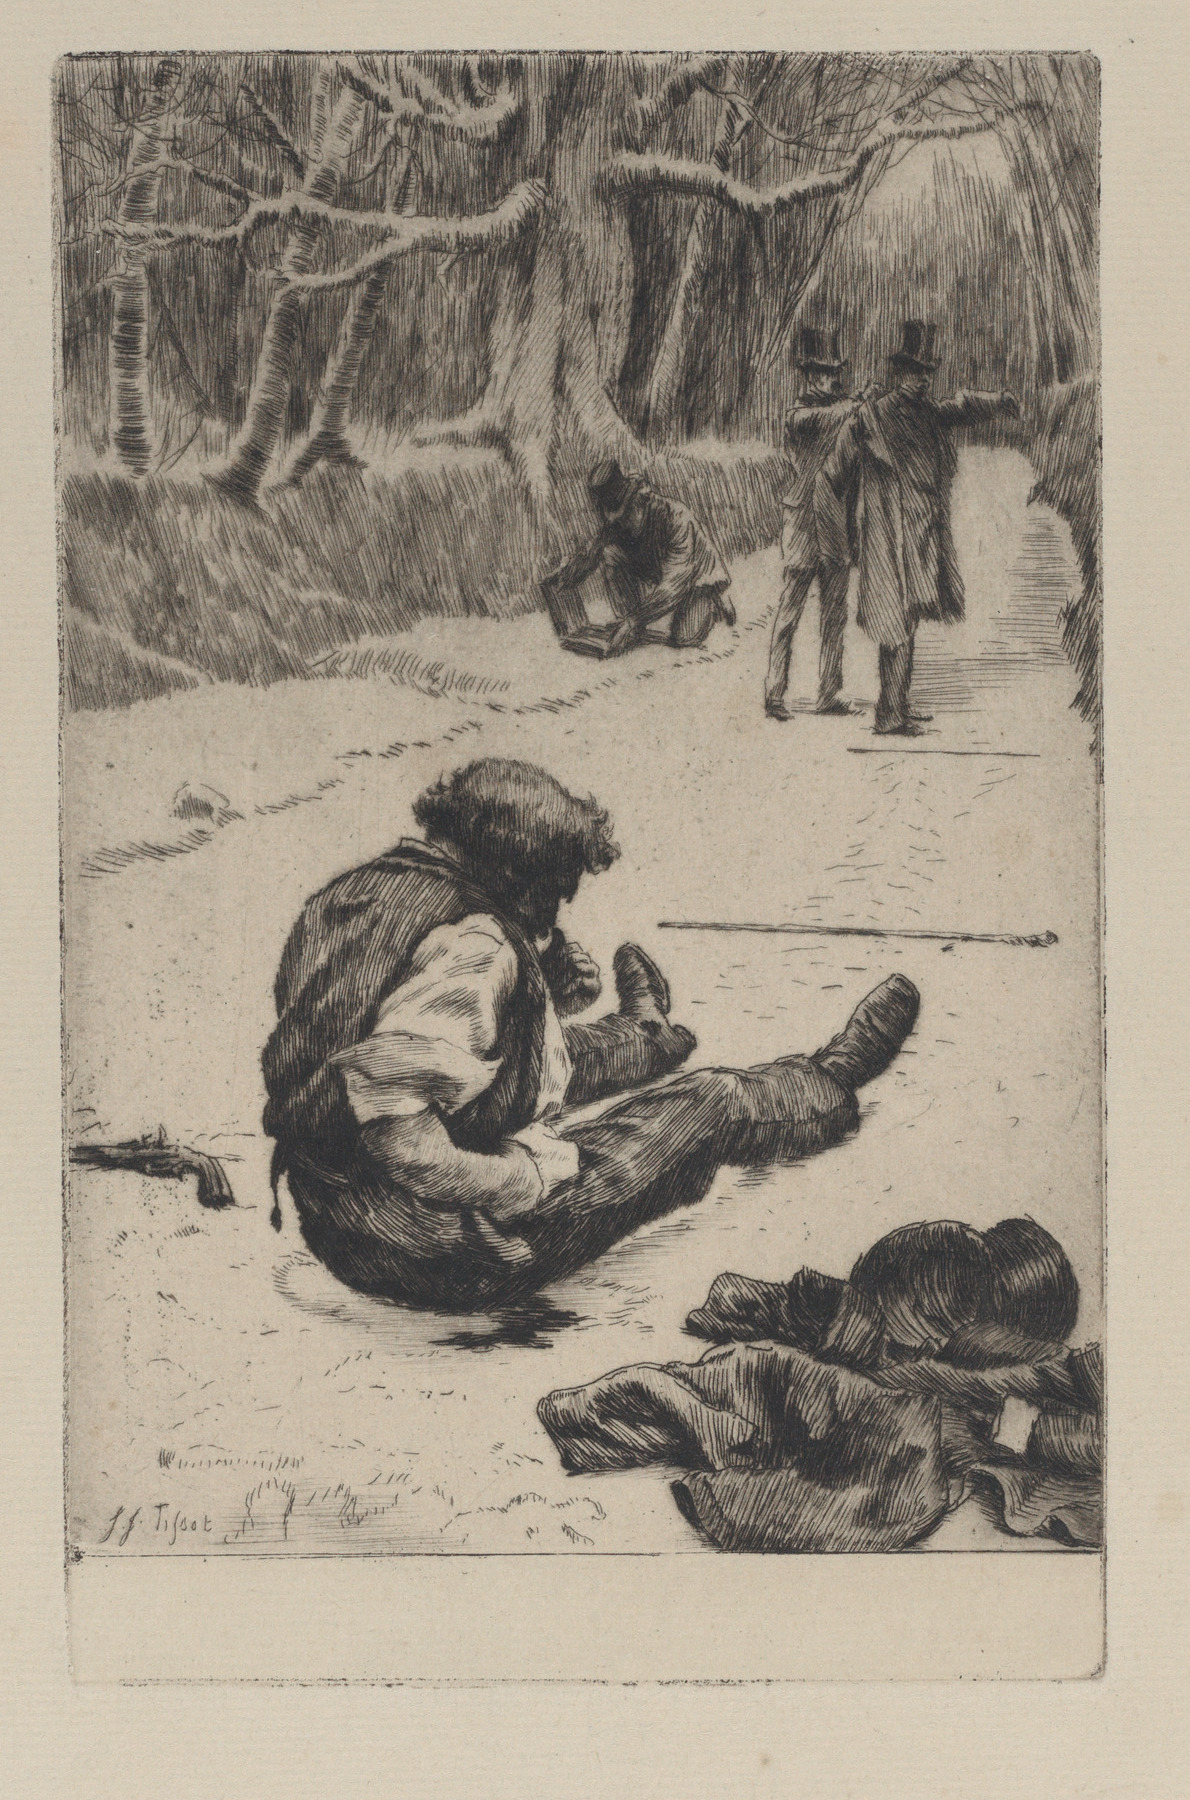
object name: print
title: Renée Mauperin: Henri Mauperin Wounded after the Duel with Boisjorand de Villacourt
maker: james tissot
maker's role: artist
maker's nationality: french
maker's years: 1836-1902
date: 1801-1900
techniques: etching